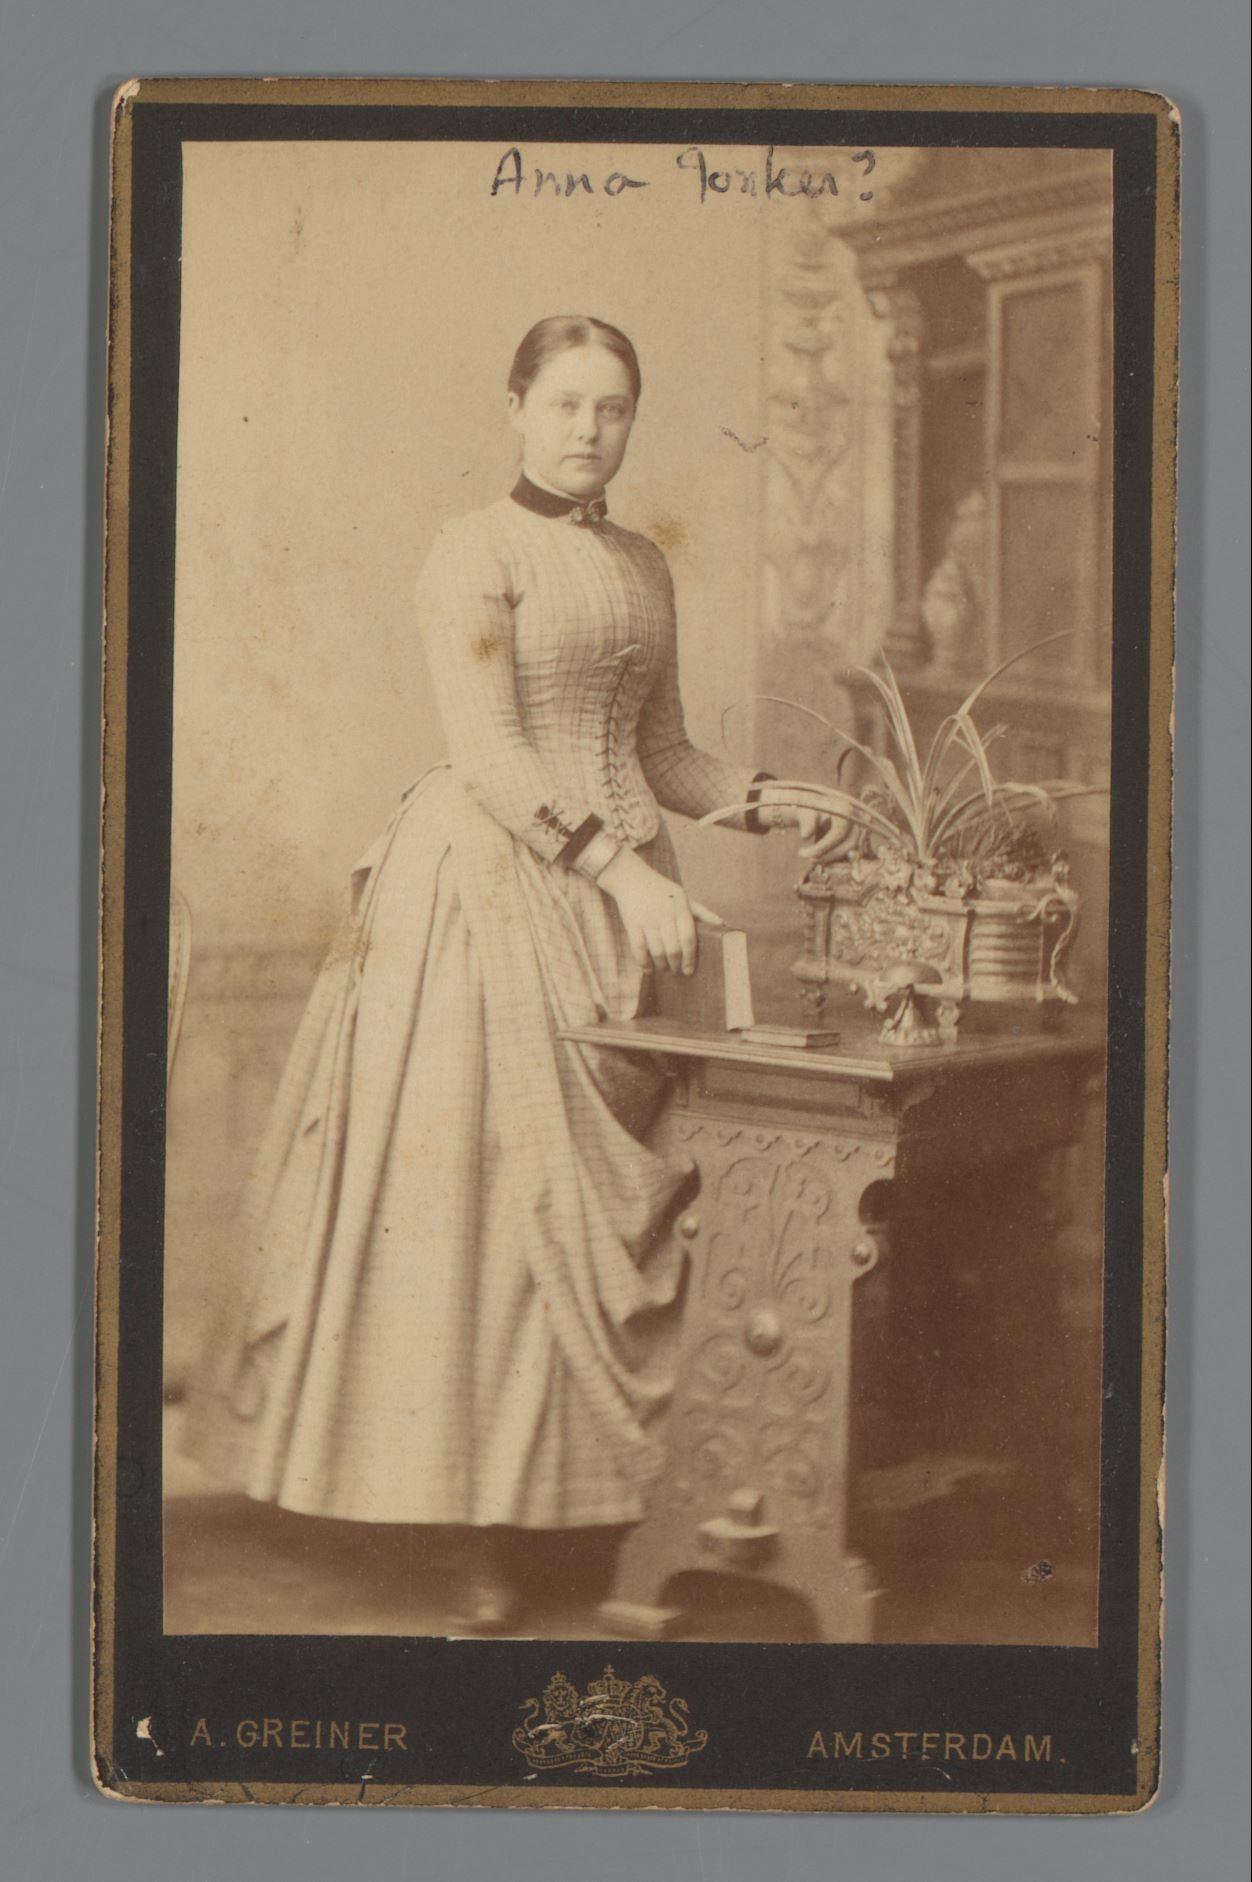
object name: carte de visite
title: Portret van Anne Gesiena Jonker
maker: albert greiner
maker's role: fotograaf, fotostudio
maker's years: 1833-1890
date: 1874-1887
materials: cardboard, photographic support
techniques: albumen print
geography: amsterdam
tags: historical persons, amsterdam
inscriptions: workshop stamp: ‘Albert Greiner/ Photograph/ Nieuwendijk 89, Amsterdam’, name: ‘Anna Jonker?’